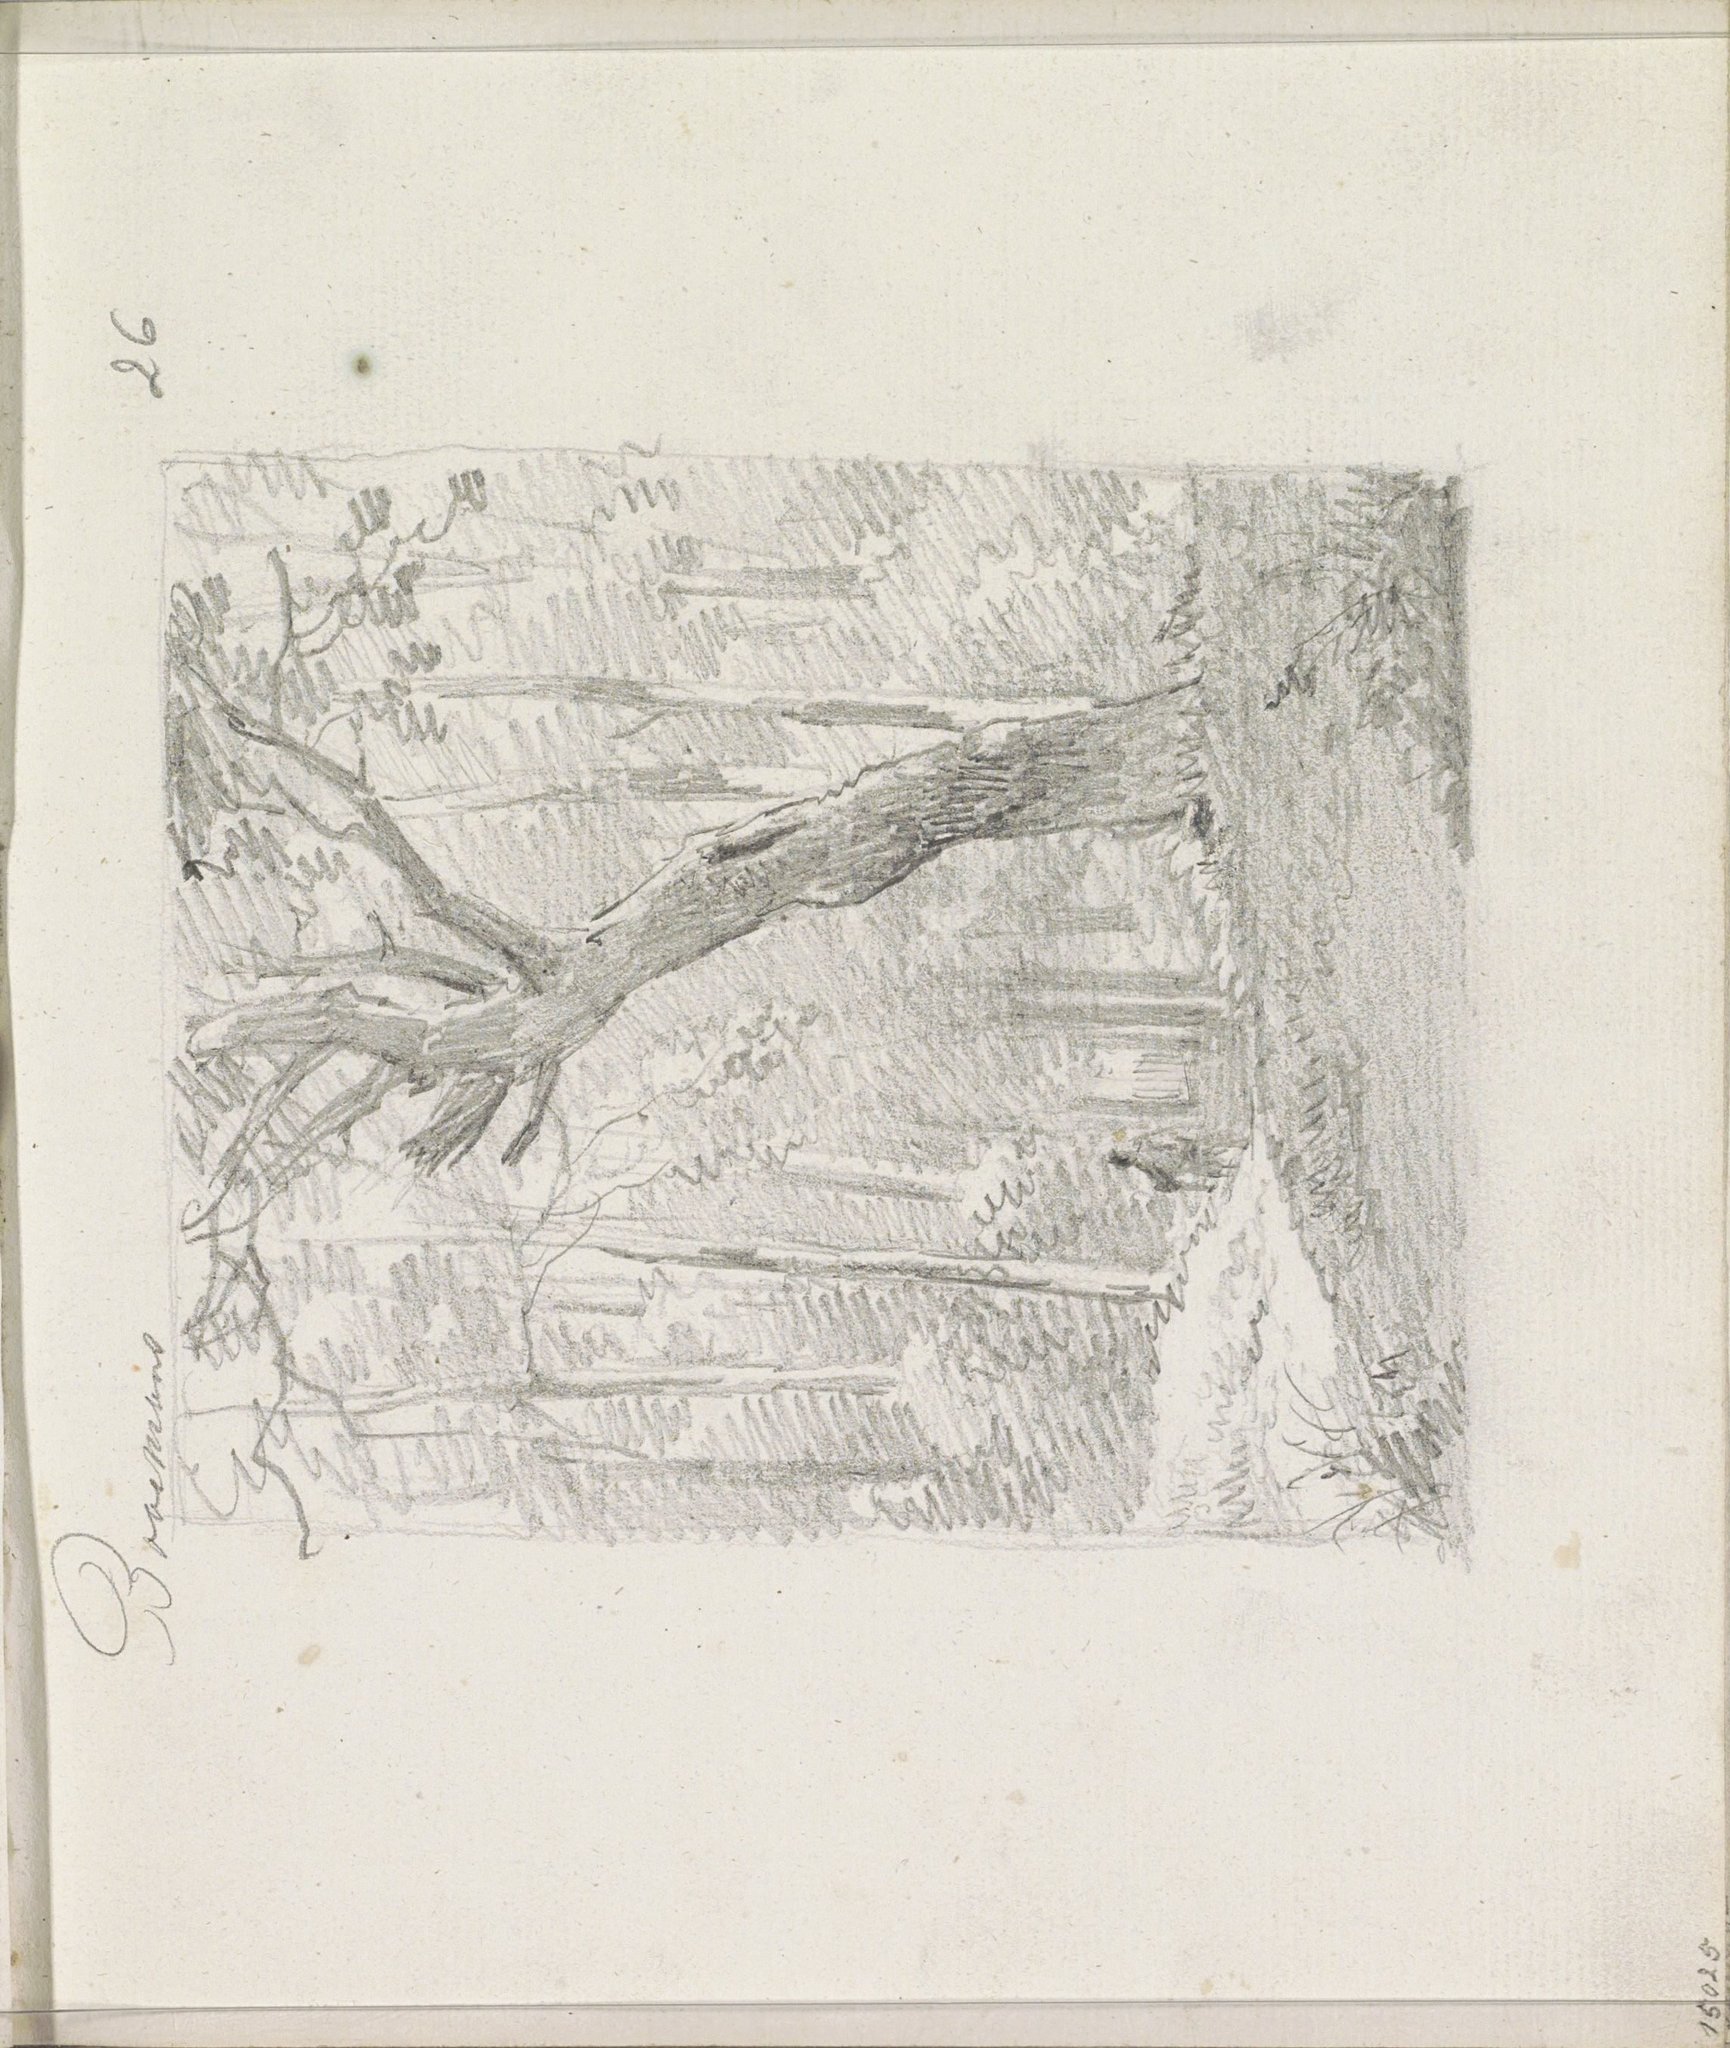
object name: sketchbook leaf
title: Man met wandelstok op een bospad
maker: andreas schelfhout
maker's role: draughtsman, painter, print maker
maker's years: 1787-1870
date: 1825-1829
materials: paper, pencil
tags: forest path or lane (+ landscape with figures, staffage)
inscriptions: number: ‘26/ 15025’, annotation: ‘Bovemans’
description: Blad 40 recto uit een schetsboek met 95 bladen.